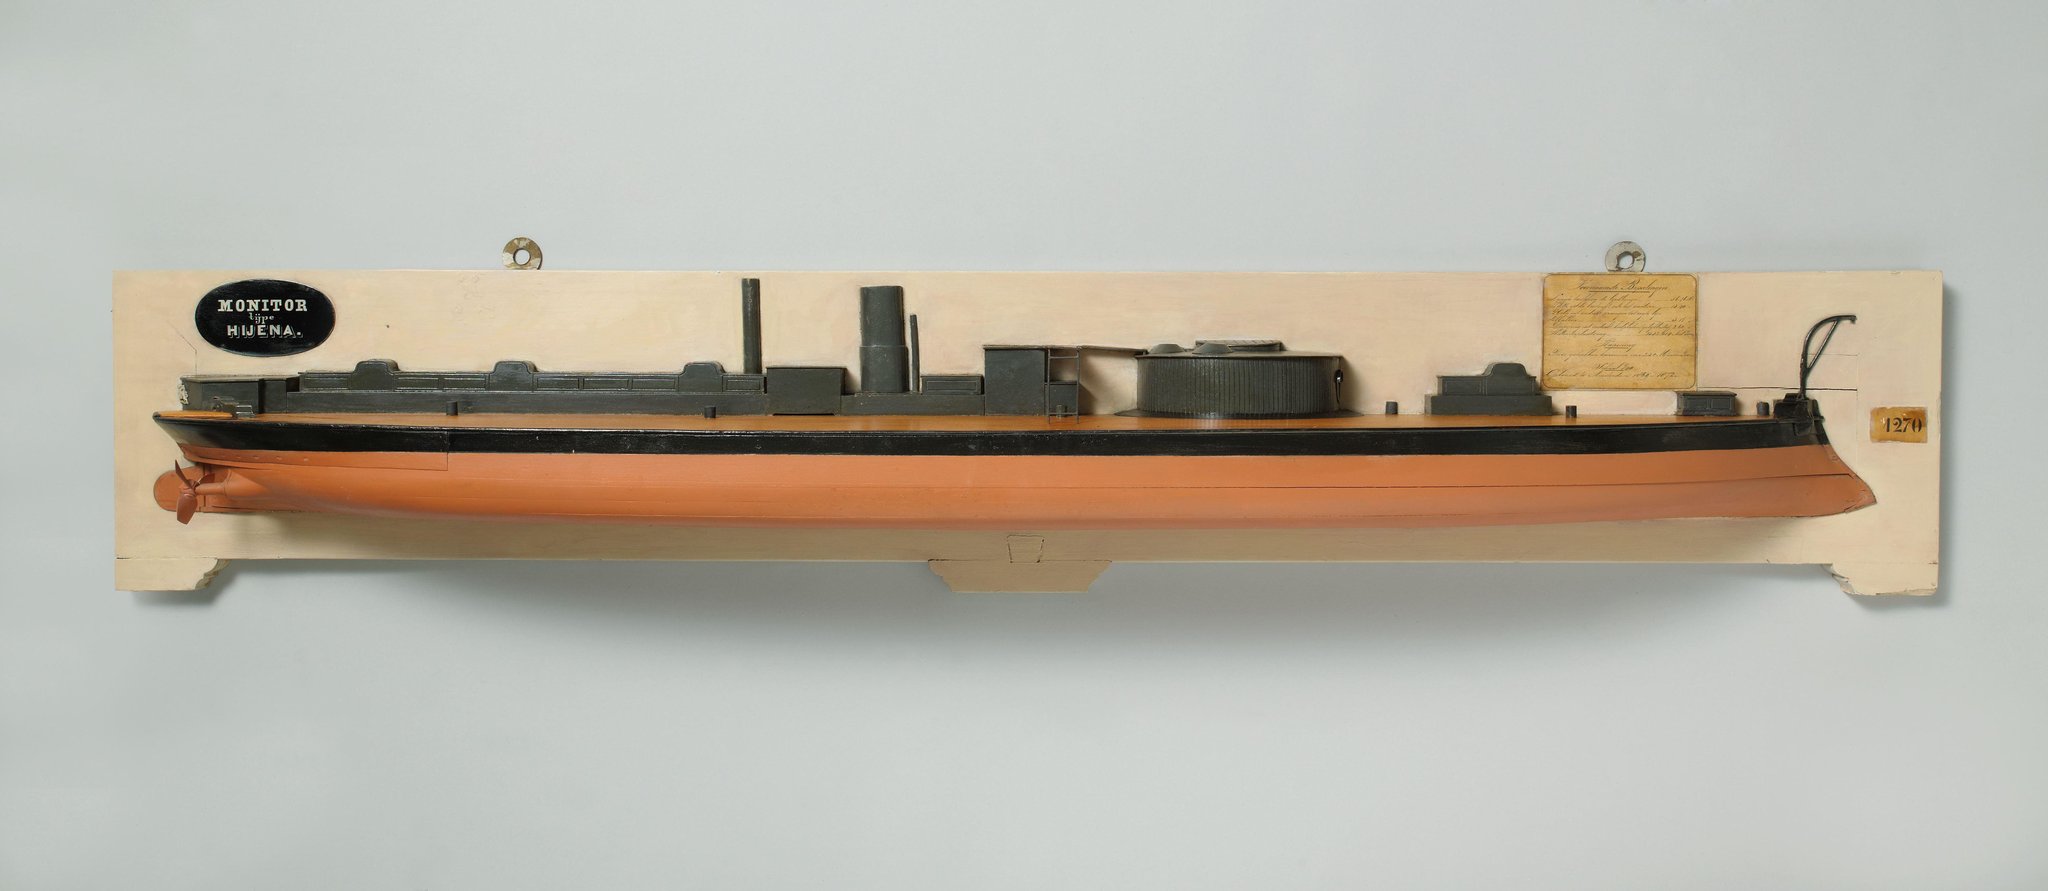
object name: builder's model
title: Half Model of a Ram Monitor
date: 1867-1869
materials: brass, wood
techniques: polychromy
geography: amsterdam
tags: hyena (schip)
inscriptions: inscription, top left, on an oval black label: ‘MONITOR / tijpe / HIJENA.’, label, centre right: ‘1270’ former inventory label, inscription, top right, on a piece of paper, in ink: ‘Voornaamste bepalingen. / [followed by measurements, armament and scale]’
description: De monitor Hyena, lang 56.76 m, met twee 23 cm kanons, werd in 1869-1870 op de Rijkswerf te Amsterdam gebouwd. De bewapening werd in 1887 gewijzigd naar een 28 cm kanon, een 7.5 cm kanon, twee 3.7 cm kanons en twee 3.7 cm revolver kanons. Zij deed alleen dienst bij de verdediging van de zeegaten; in 1888 uit dienst wegens averij, in 1905 van de sterkte afgevoerd en in 1906 voor de sloop verkocht.